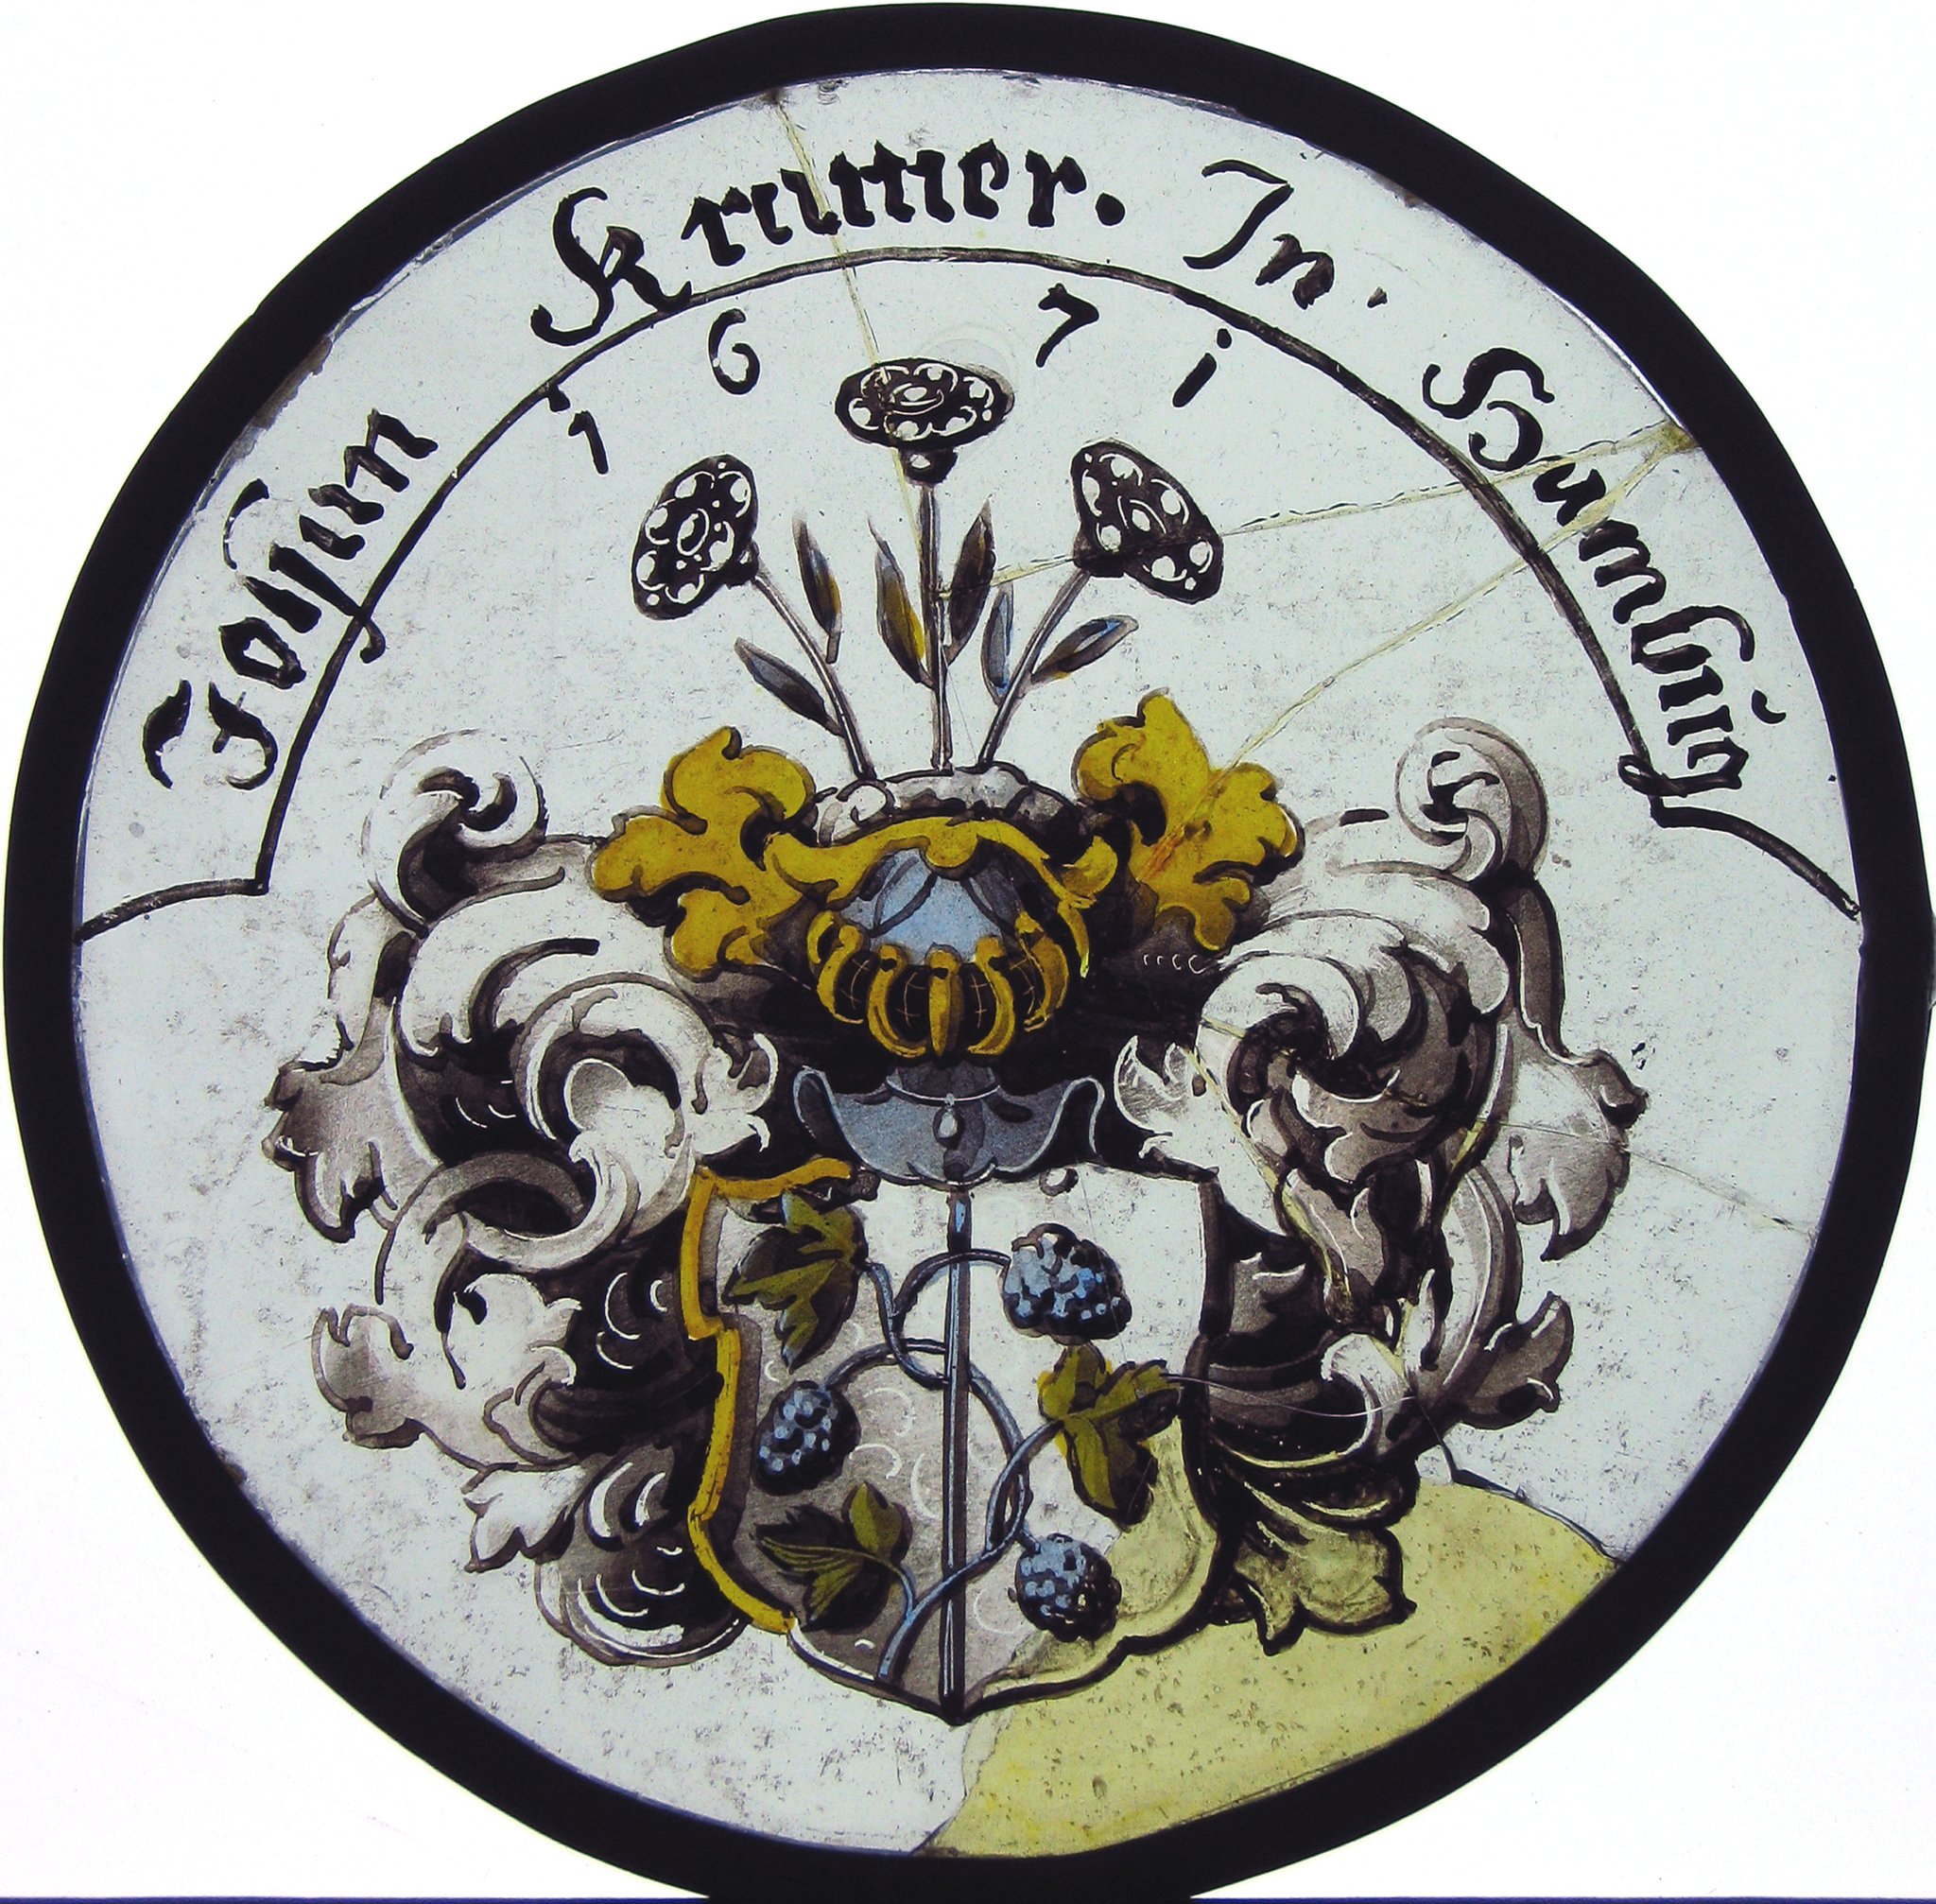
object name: roundel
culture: german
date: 1671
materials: glass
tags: coat of arms